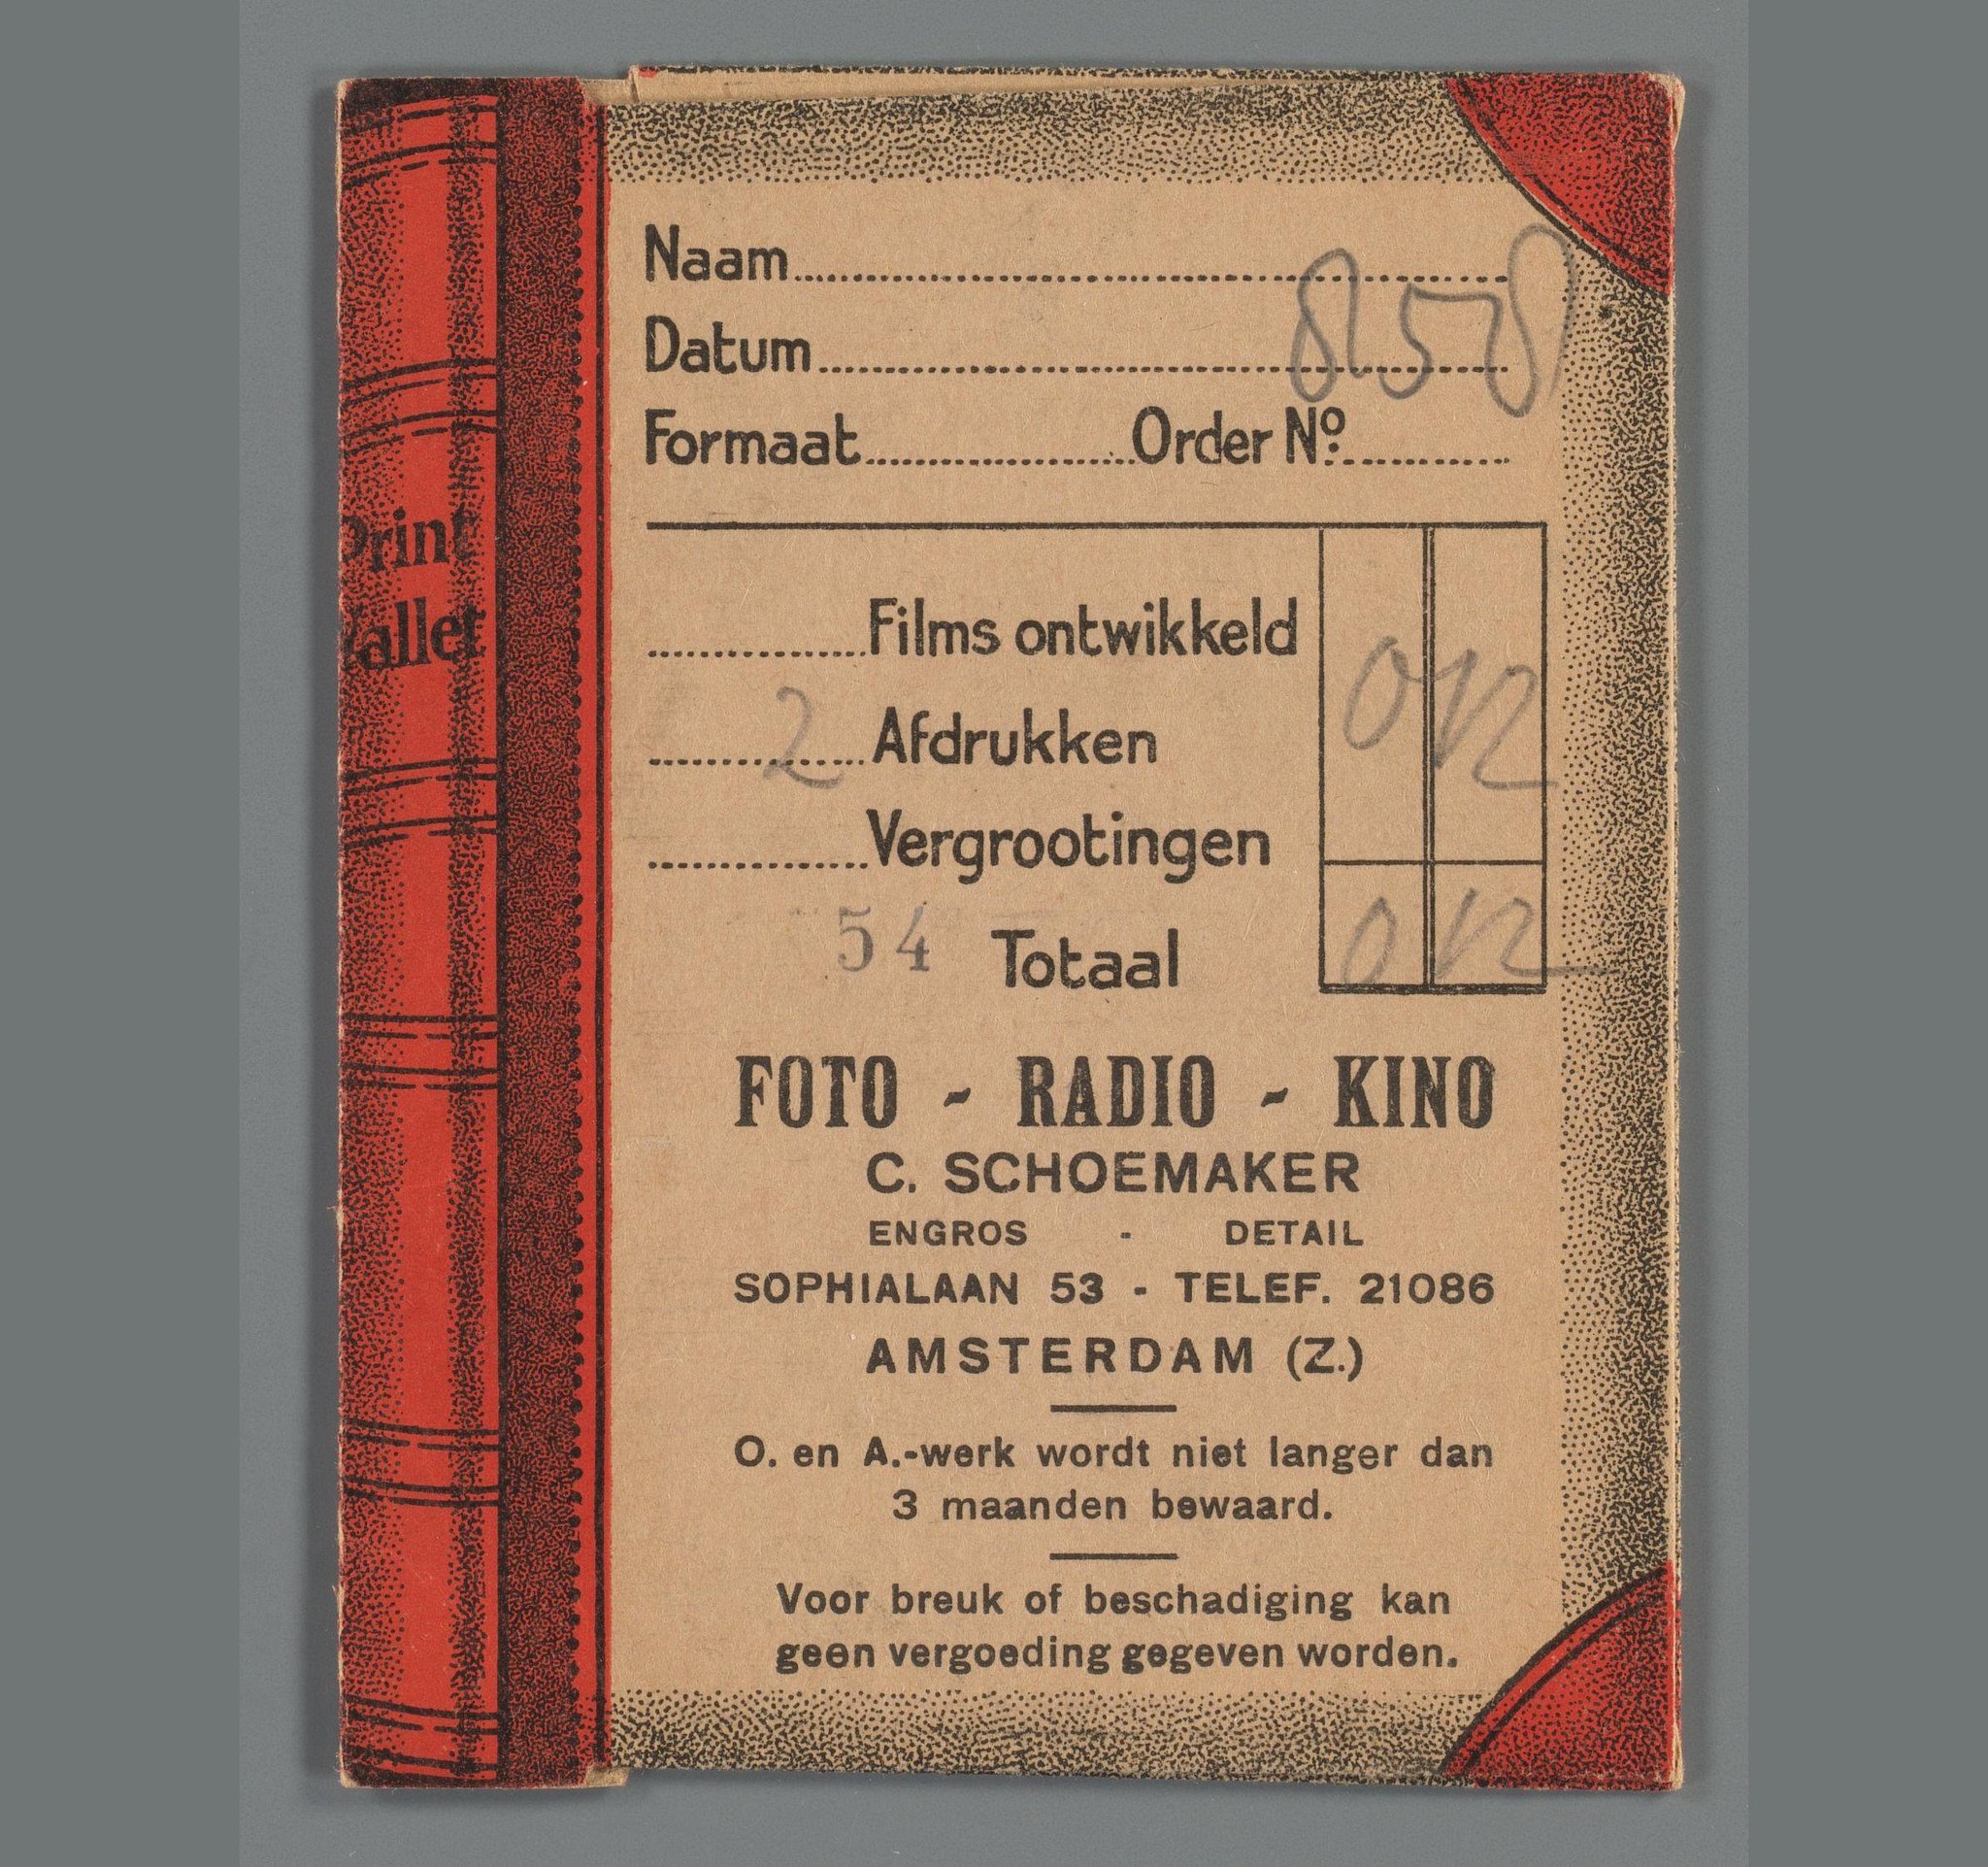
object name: photomap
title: Print Wallet Foto - Radio - Kino C. Schoemaker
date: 1920-1940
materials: paper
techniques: letterpress printing, printing block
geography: amsterdam